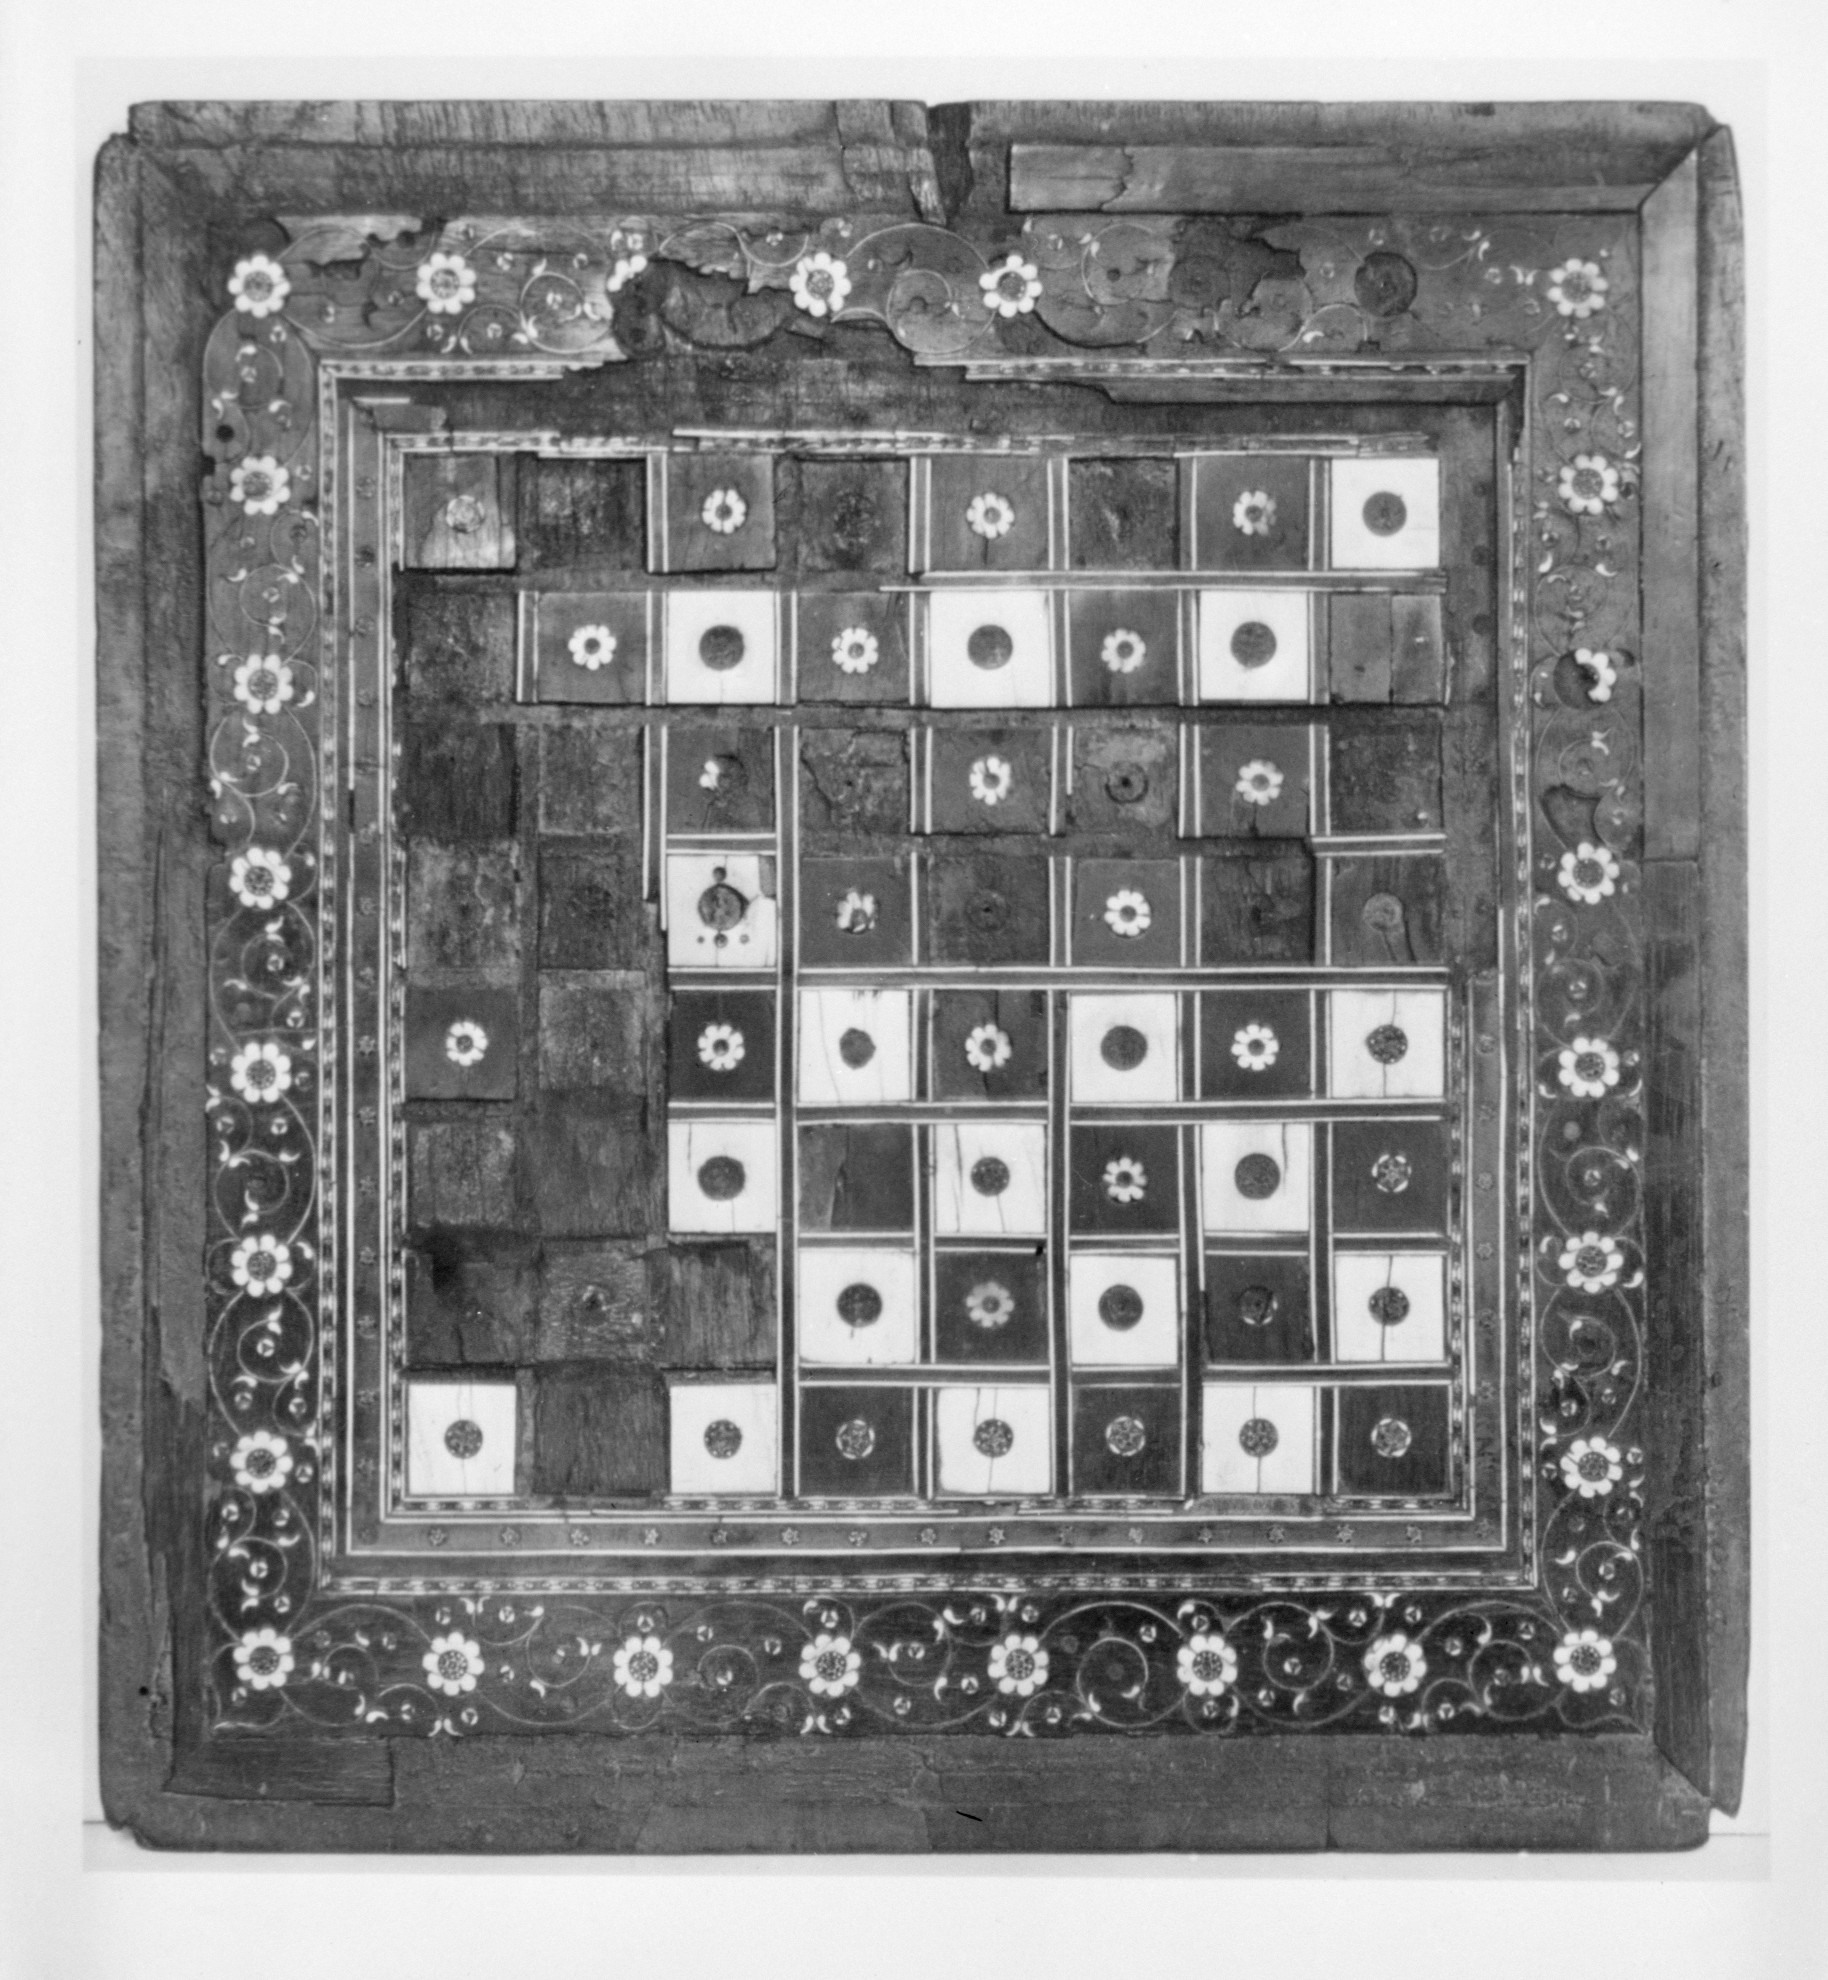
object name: chessboard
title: Chess and goose game board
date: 1701-1800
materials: brass, ivory, wood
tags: chess